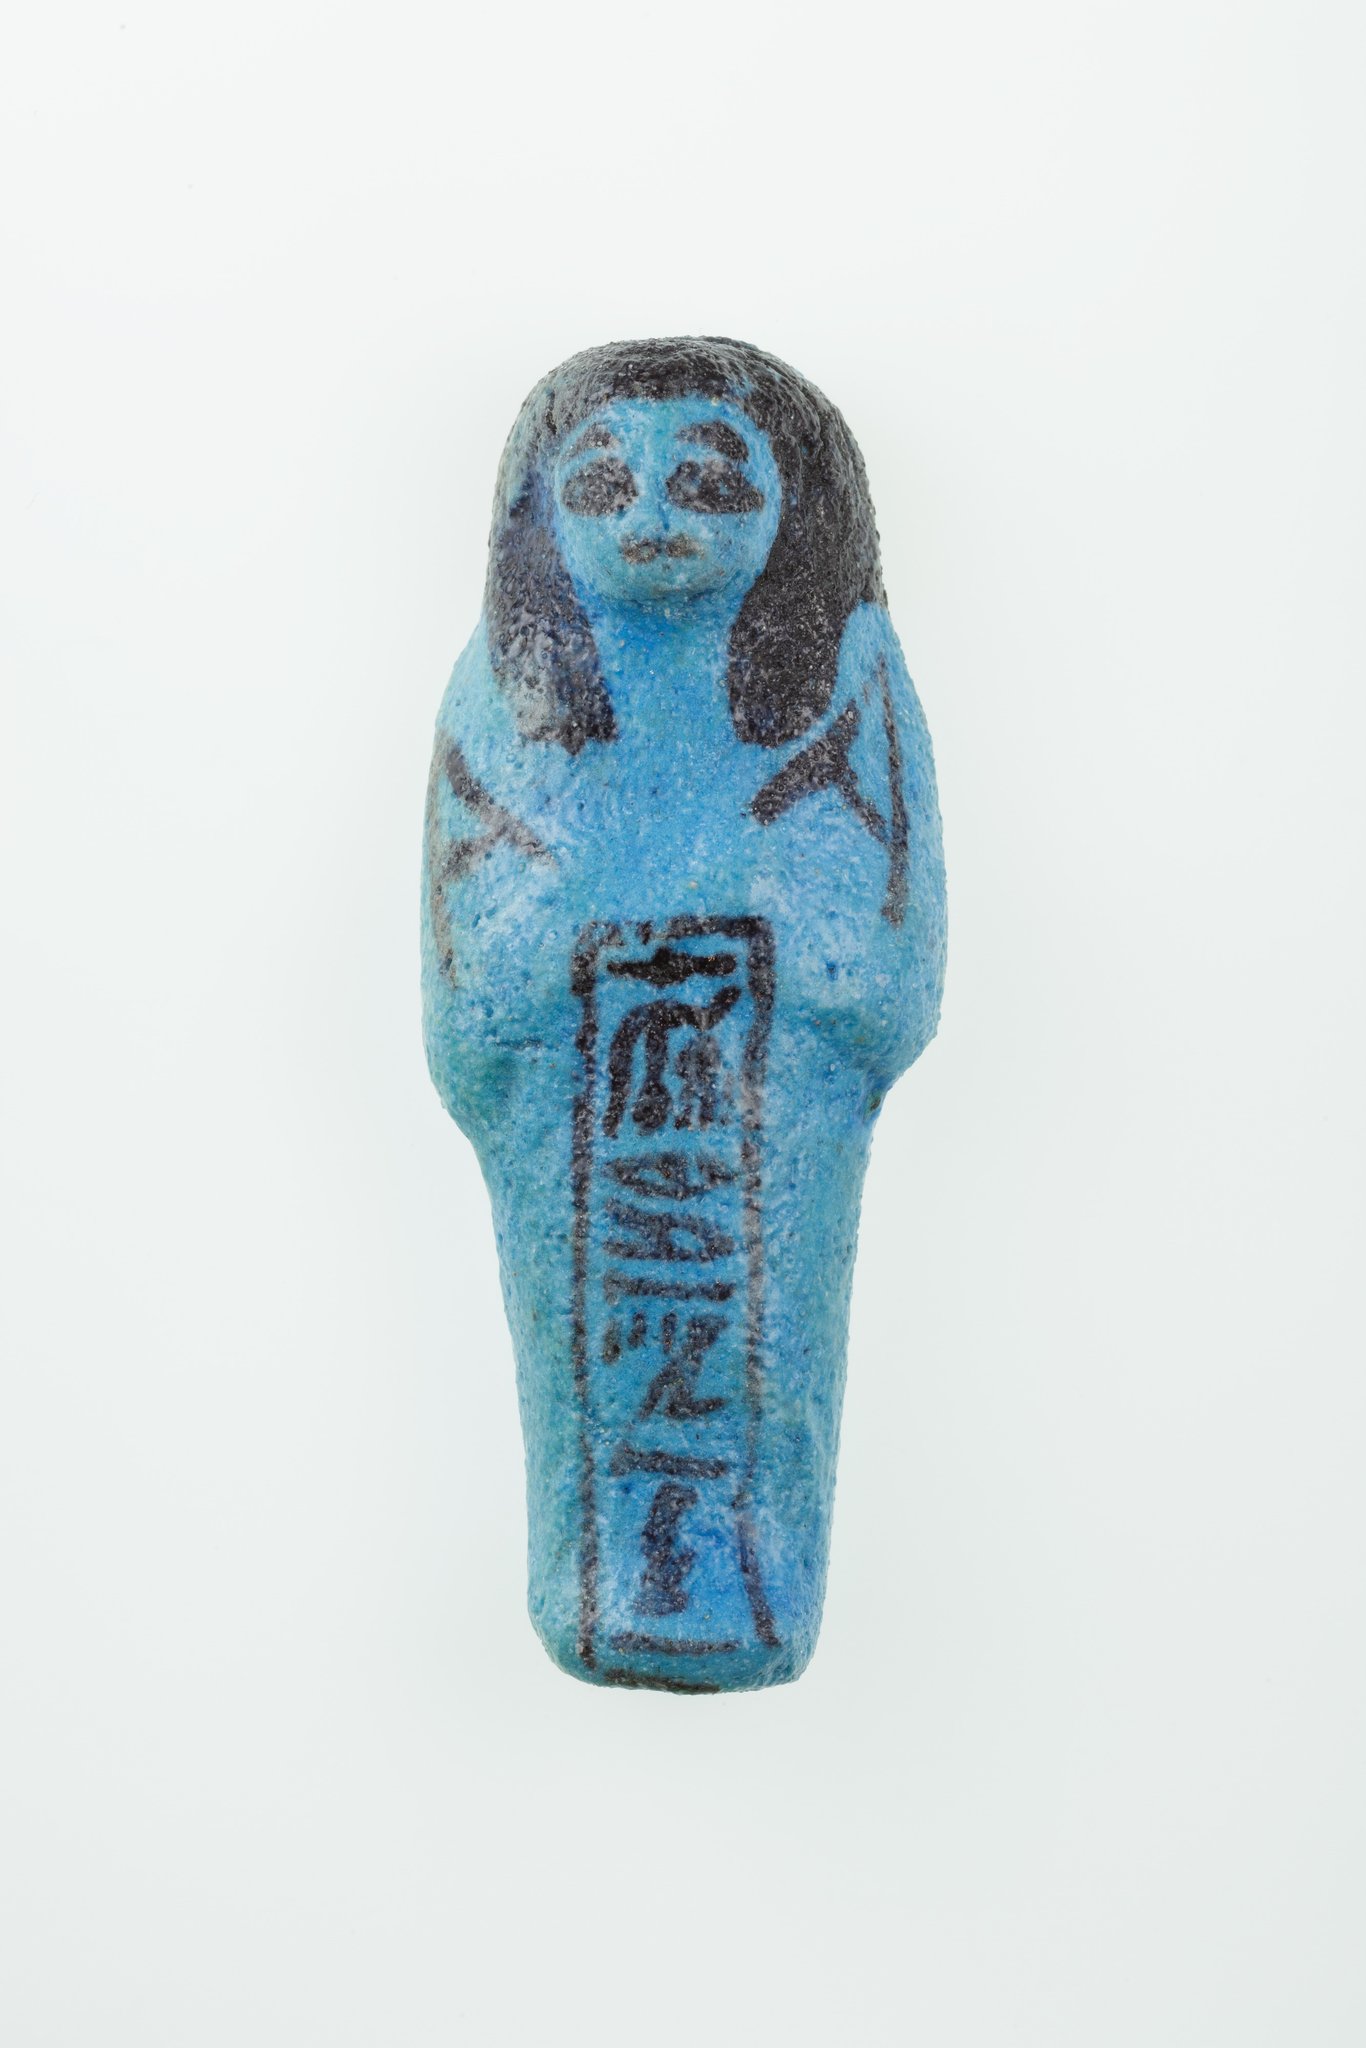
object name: shabti, worker, nauny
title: Worker Shabti of Nauny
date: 1050 BCE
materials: faience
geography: egypt